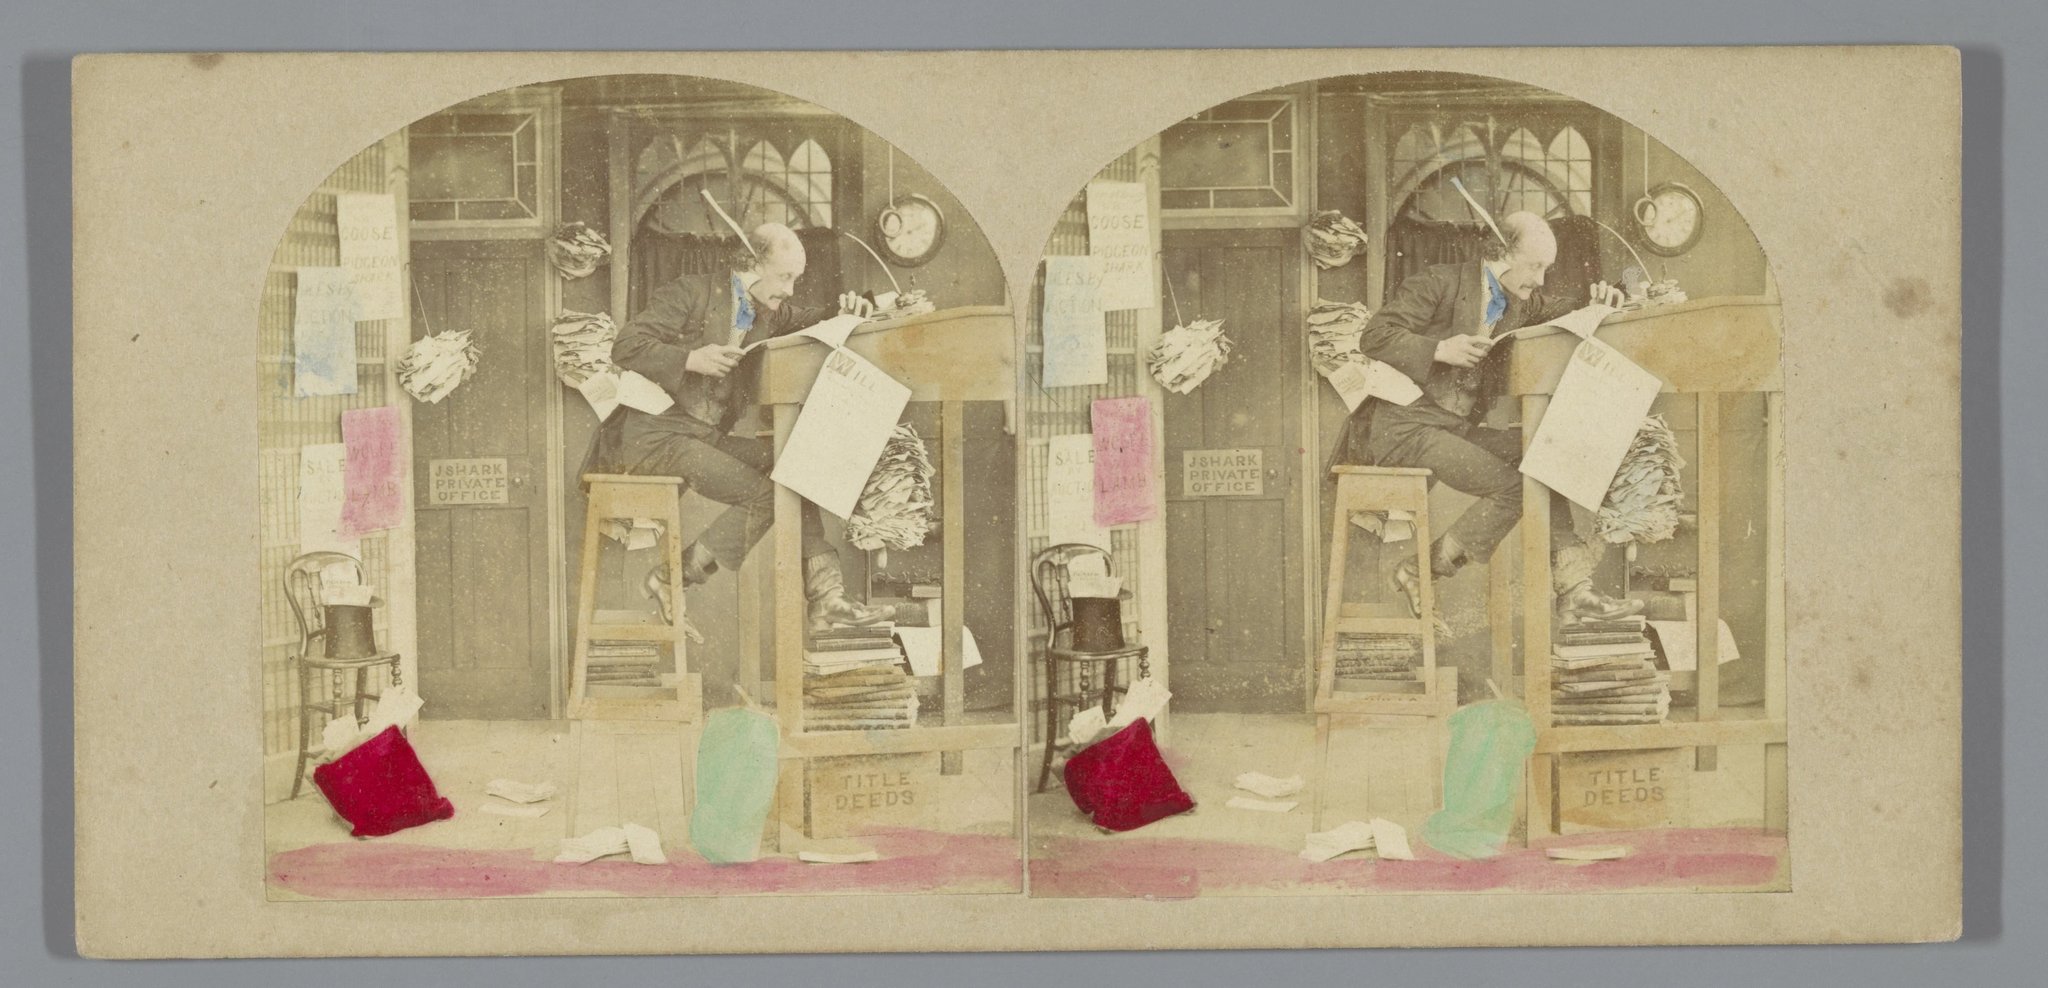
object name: stereograph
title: John Quill, de klerk van Robert Shark, zittend op een hoge kruk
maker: Anonymous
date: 1852-1863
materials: cardboard, paper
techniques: albumen print, hand coloring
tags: sales clerk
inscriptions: inscription: ‘John Quill./ John Quill was clerk to Robert Shark, a legal man was he, (...)’